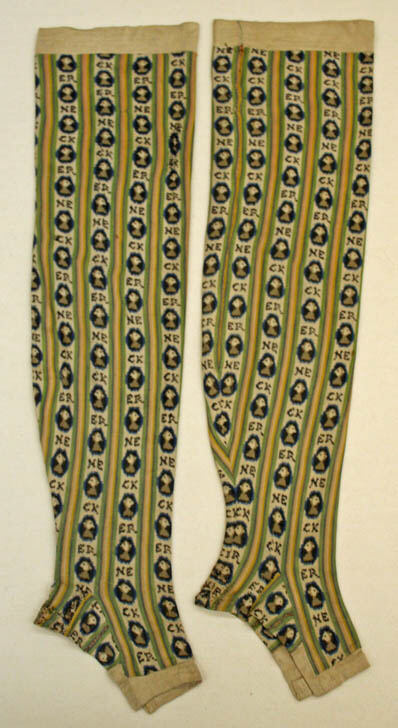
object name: stocking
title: Stockings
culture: french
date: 1788-1793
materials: silk